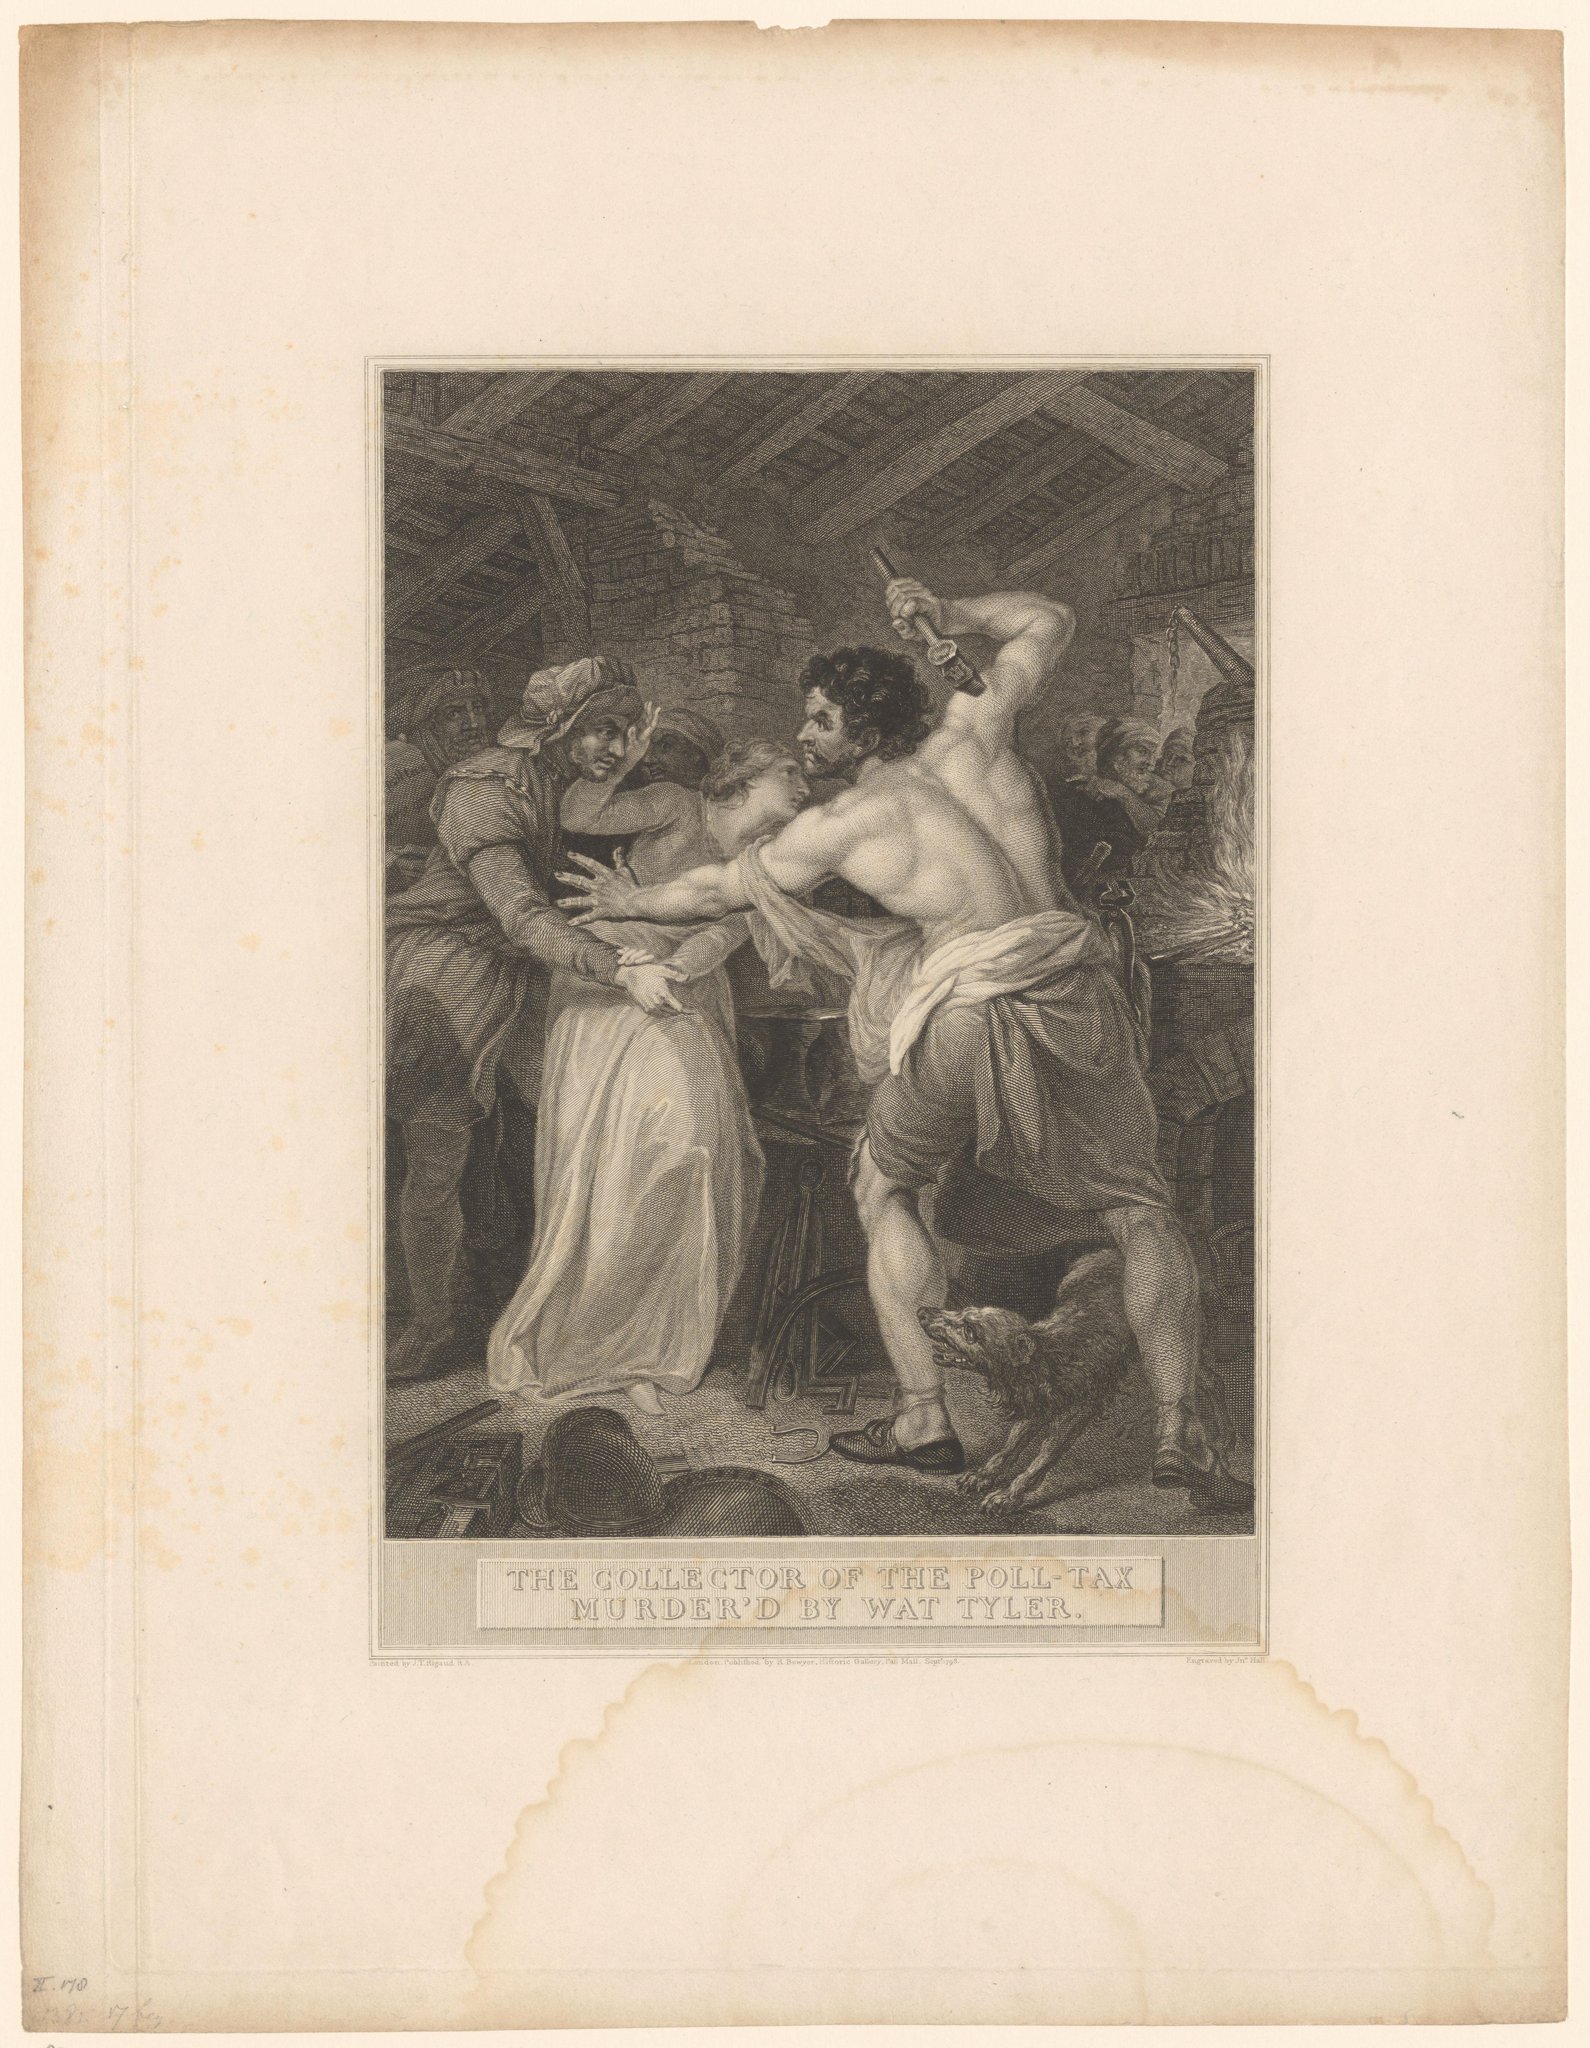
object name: book illustration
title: Wat Tyler vermoordt een belastinginner met een hamer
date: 1798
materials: paper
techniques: etching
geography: london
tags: tools, aids, implements ~ crafts and industries: hammer, murder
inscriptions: collector's mark: Lugt 2228